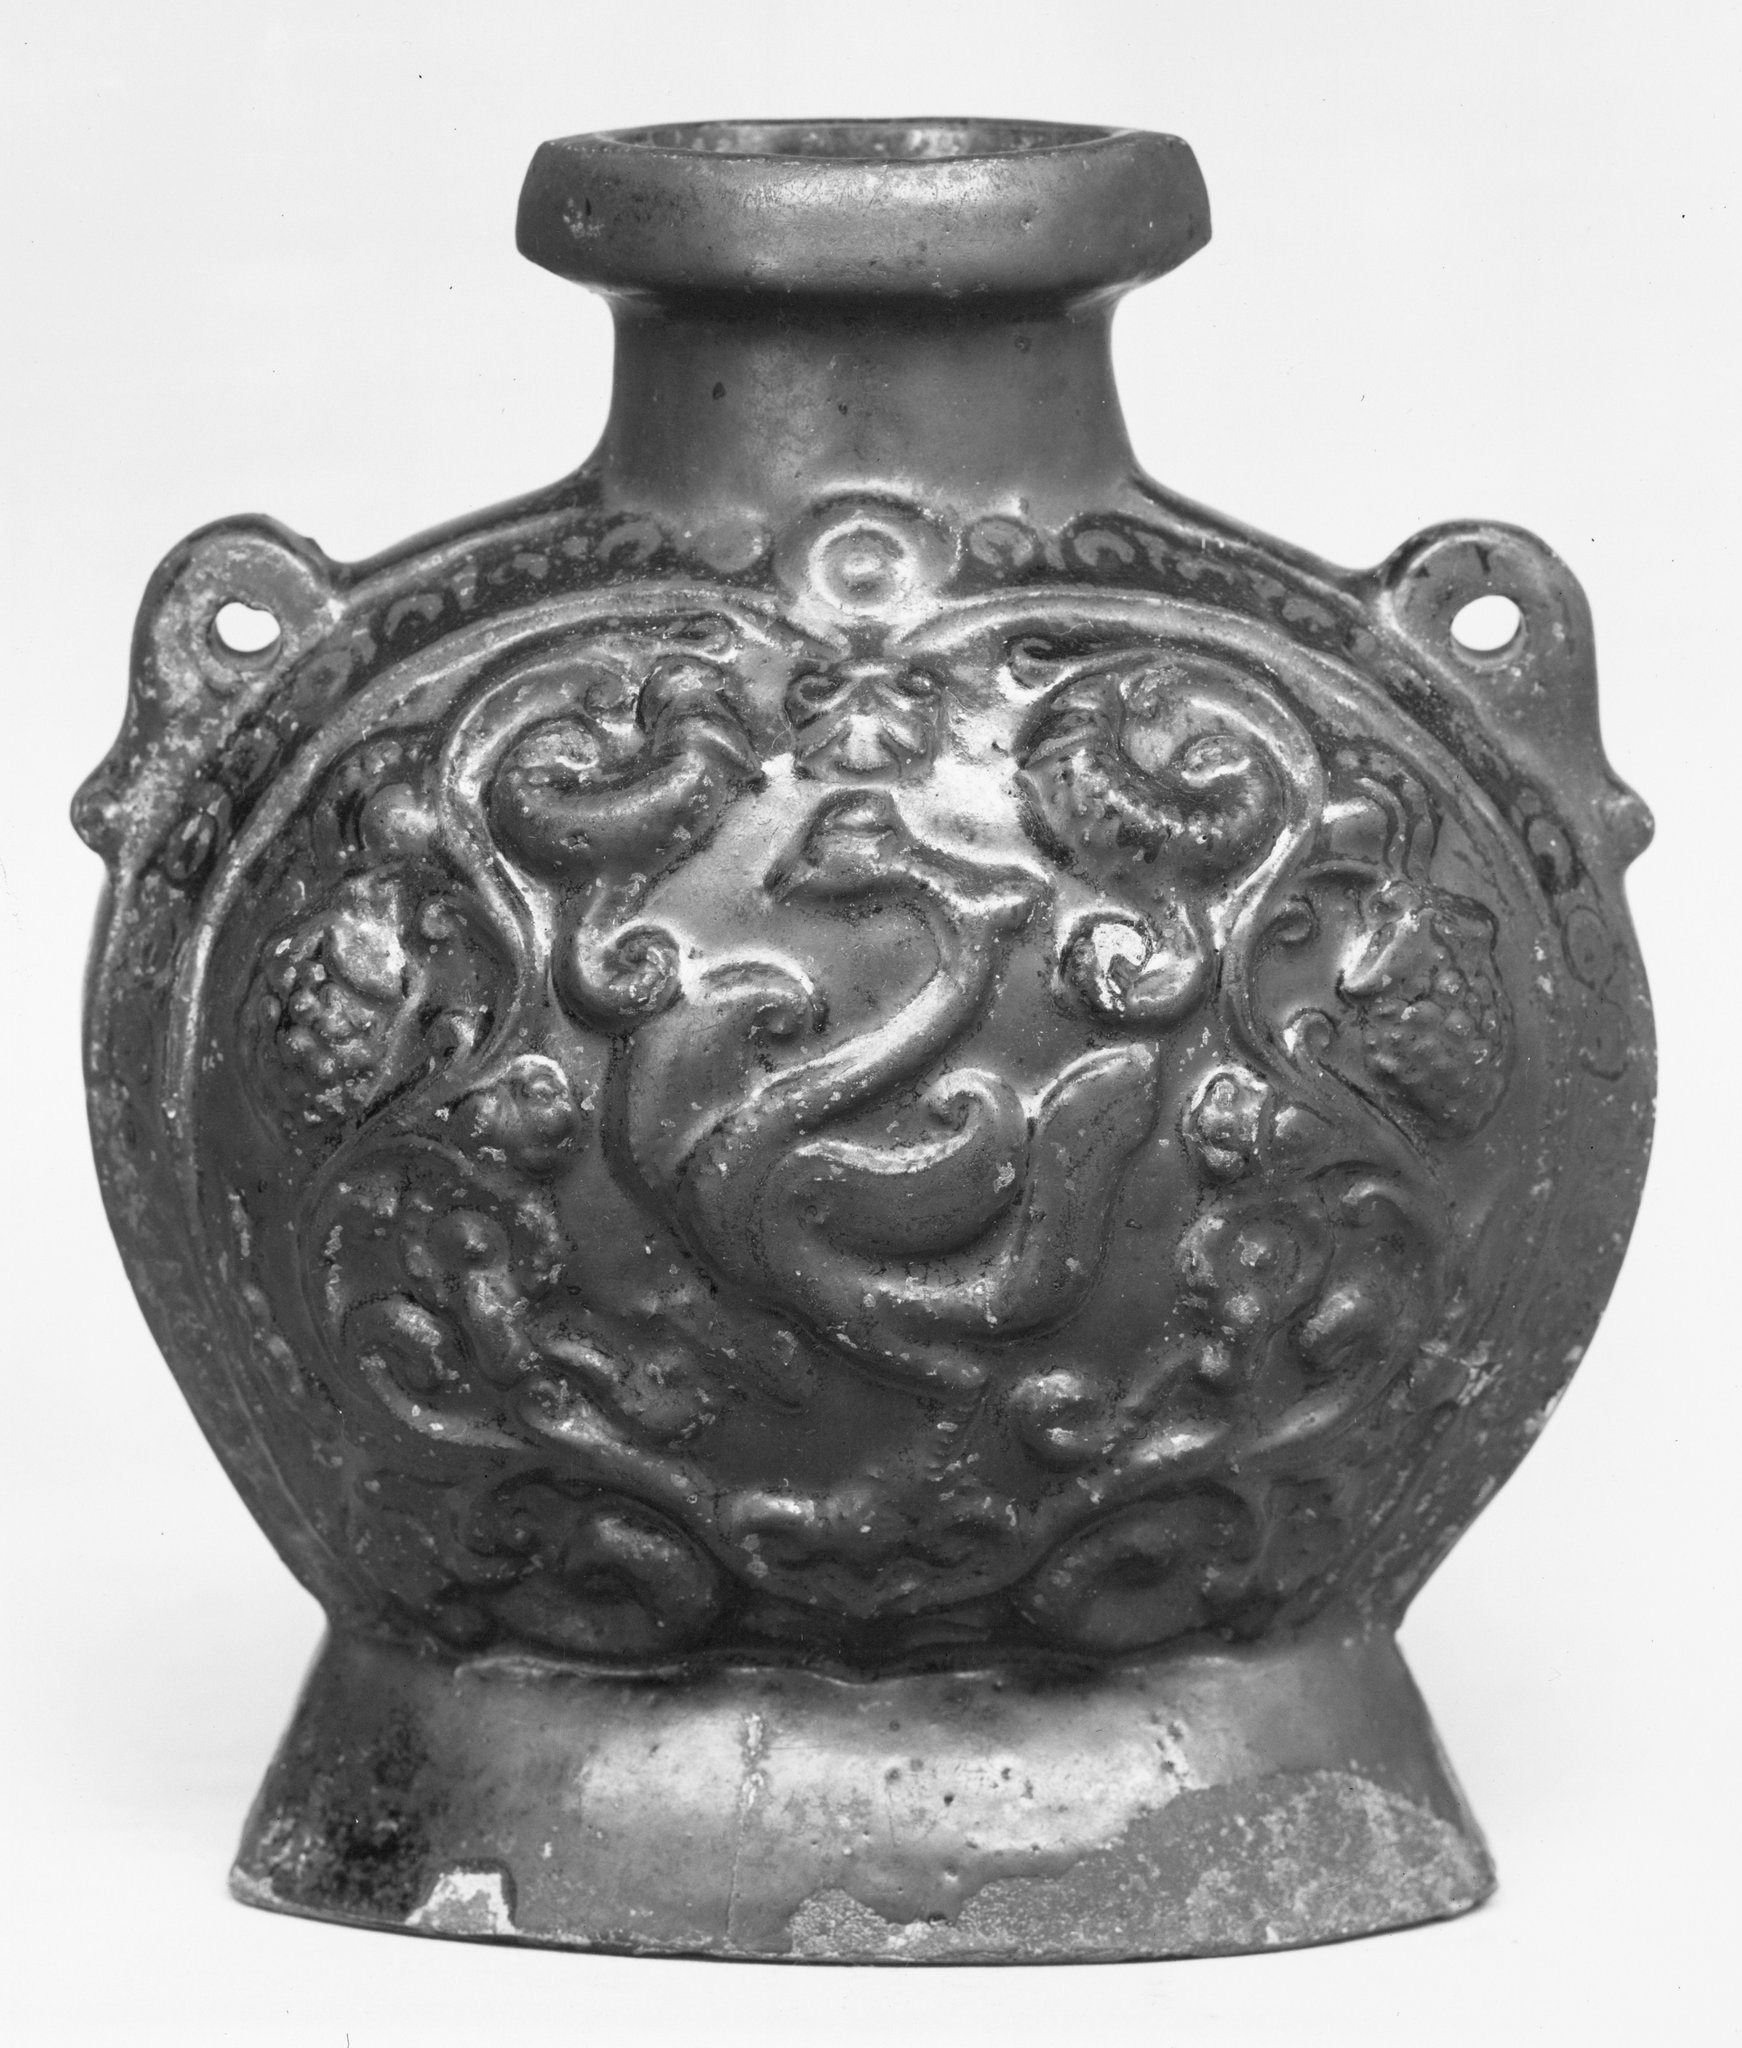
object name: jar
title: Flask with molded decoration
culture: chinese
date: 567-700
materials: glaze, stoneware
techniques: molding